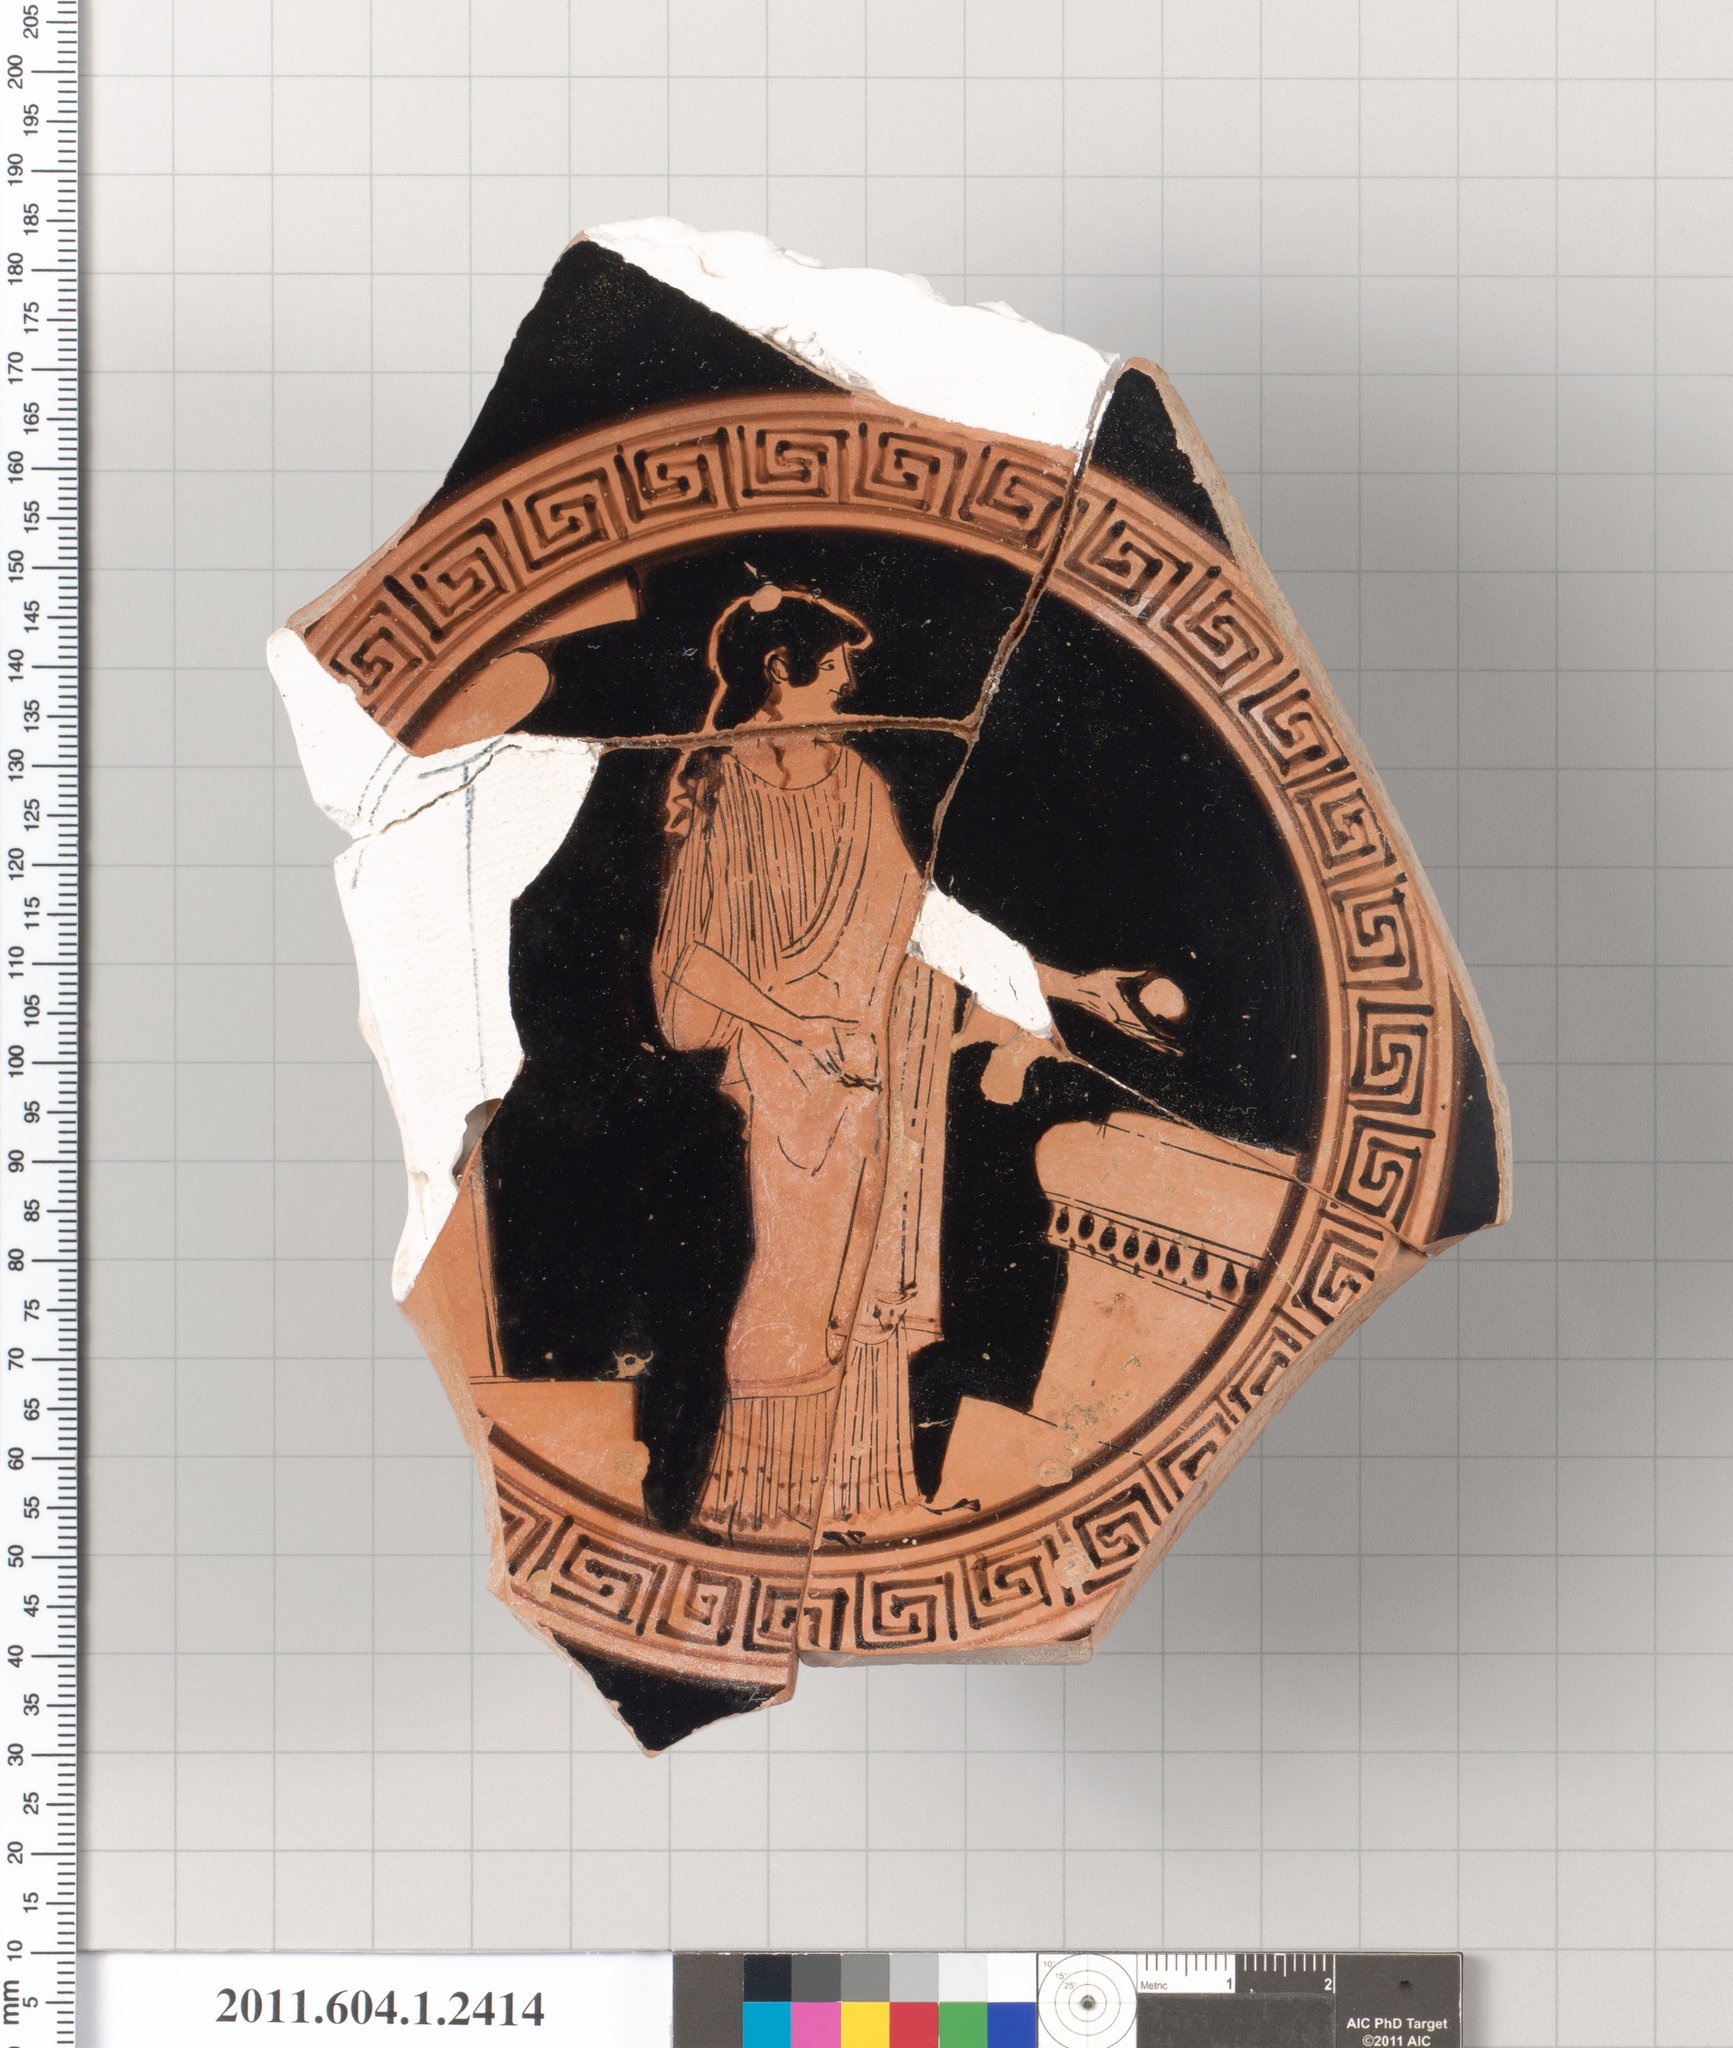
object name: kylix fragment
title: Terracotta fragment of a kylix (drinking cup)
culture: greek, attic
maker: stieglitz painter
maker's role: artist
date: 480-470 BCE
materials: terracotta